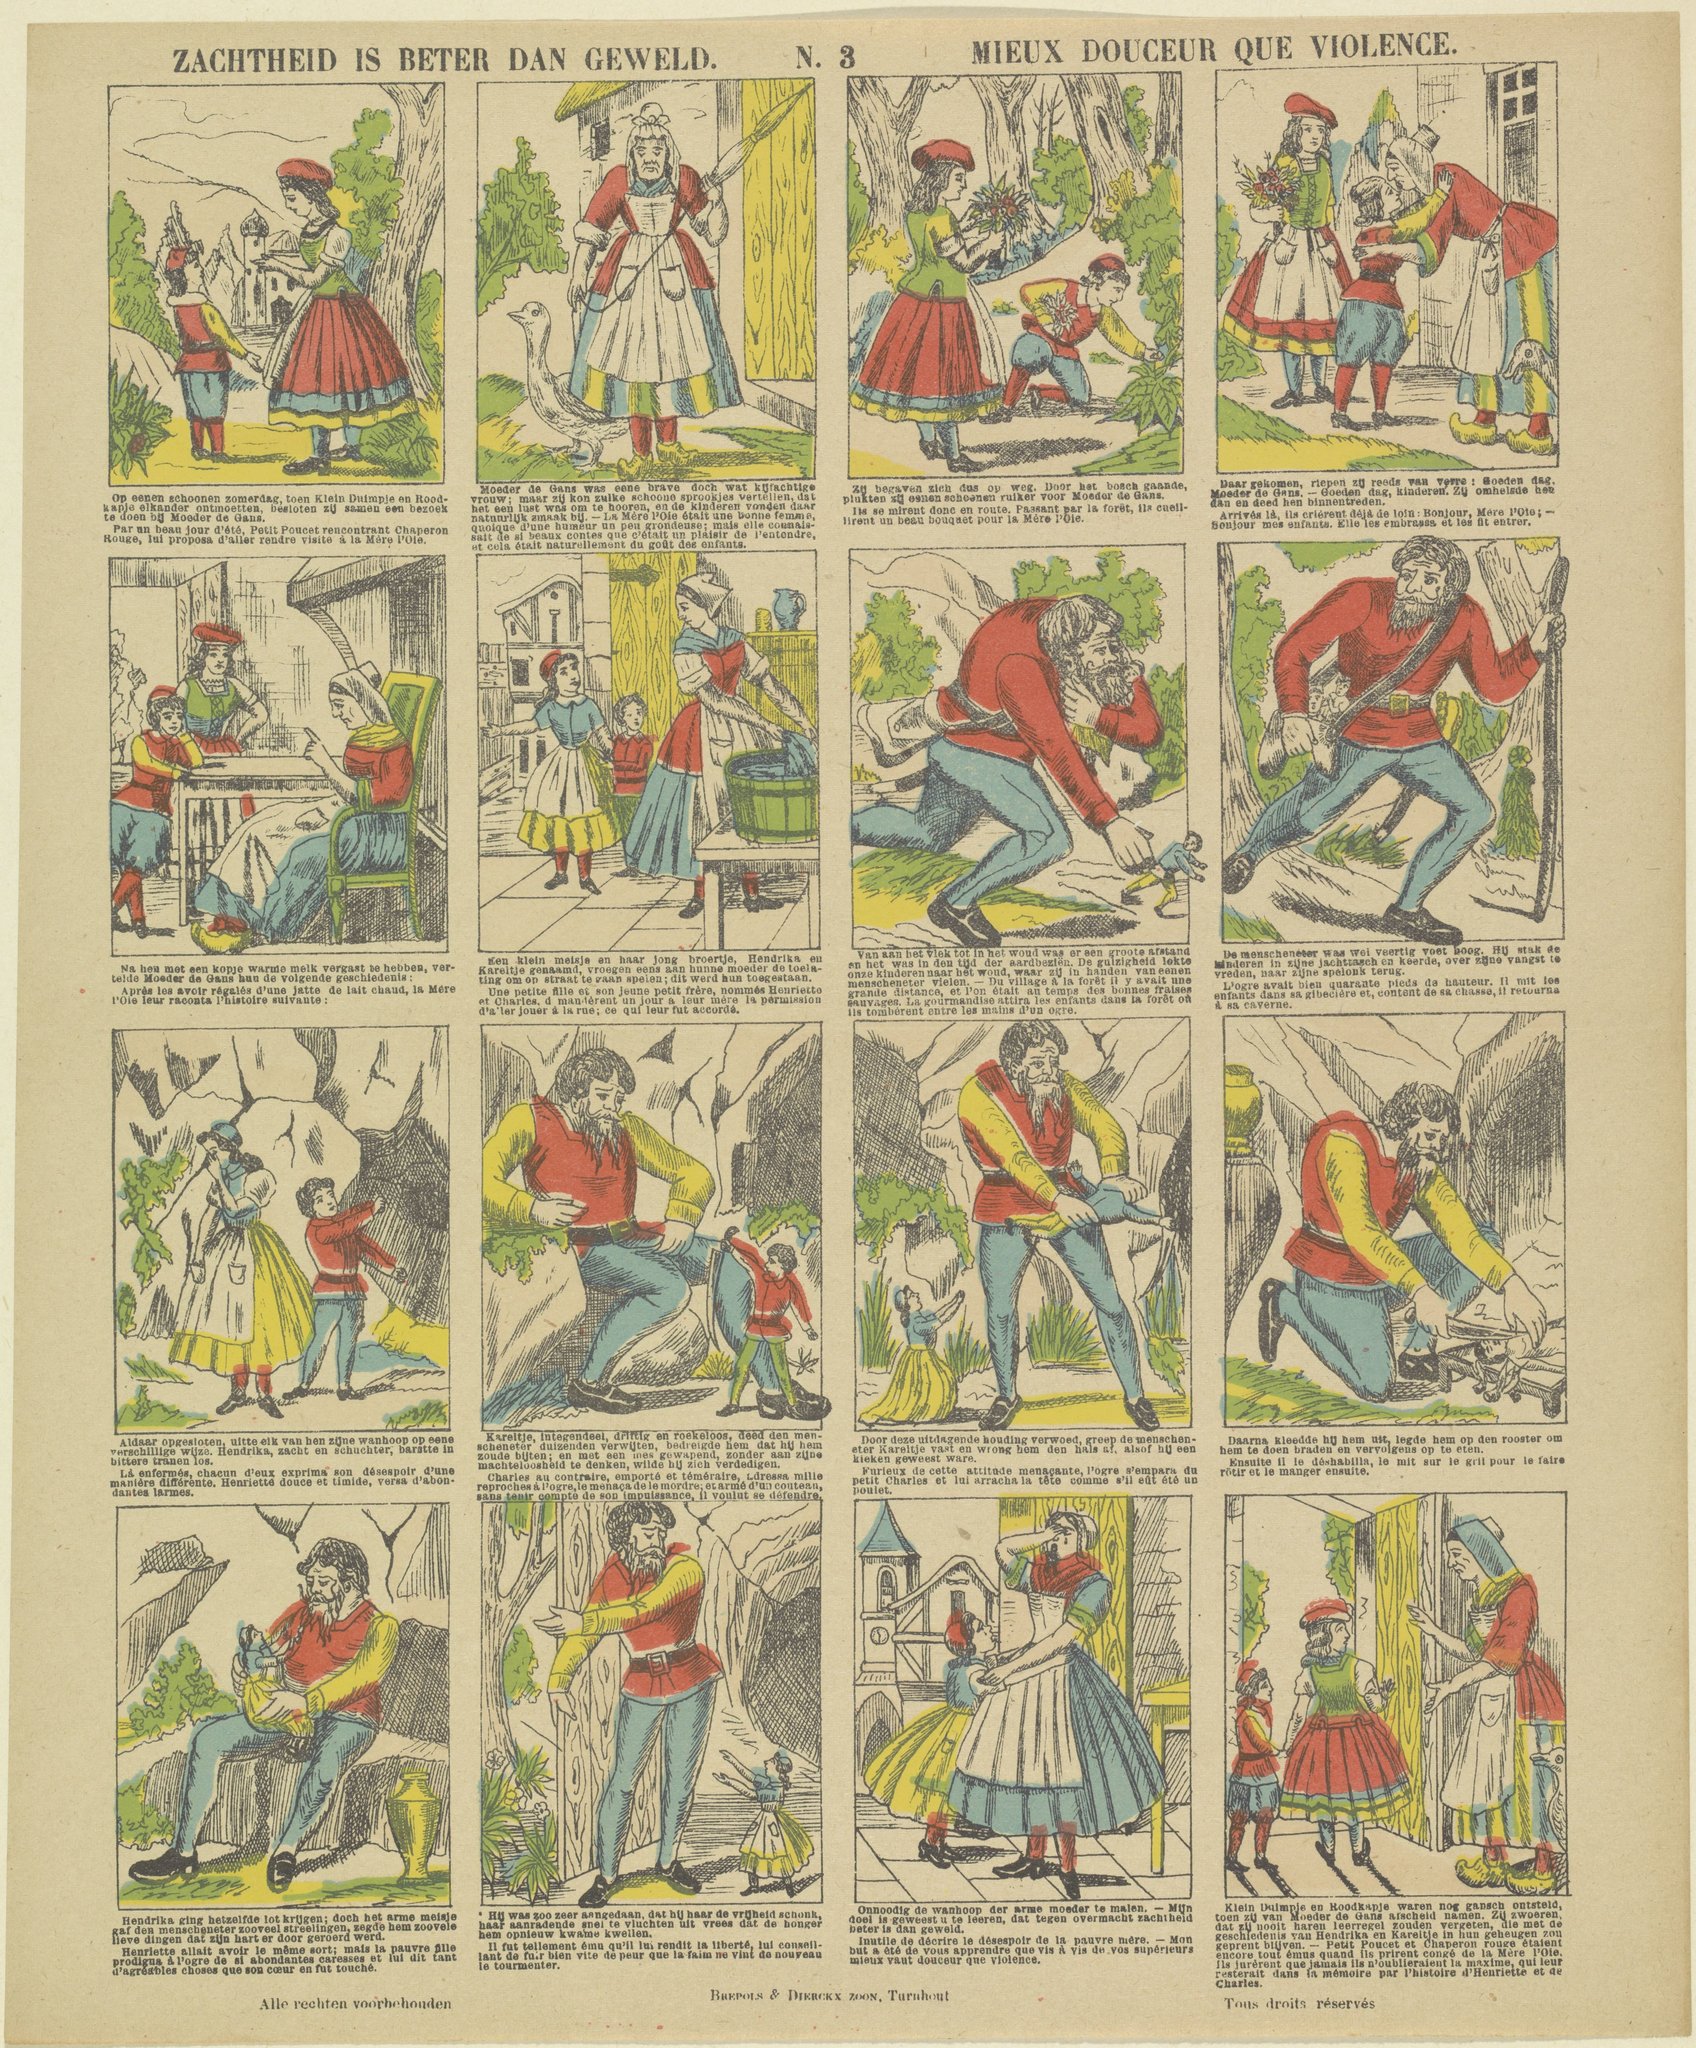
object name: popular print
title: Zachtheid is beter dan geweld / Mieux douceur que violence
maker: Anonymous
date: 1833-1911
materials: paper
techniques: lithograph, letterpress printing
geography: turnhout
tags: tales and fairy tales, tales and fairy tales: little red riding-hood, cannibalism, tales and fairy tales: little thumbling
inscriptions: collector's mark: Lugt 2760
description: Blad met 16 voorstellingen over Moeder Gans die Roodkapje en Klein Duimpje een verhaal over een mensenetende reus verteld. Onder elke afbeelding een onderschrift in het Nederlands en in het Frans. Genummerd midden boven: N. 3.